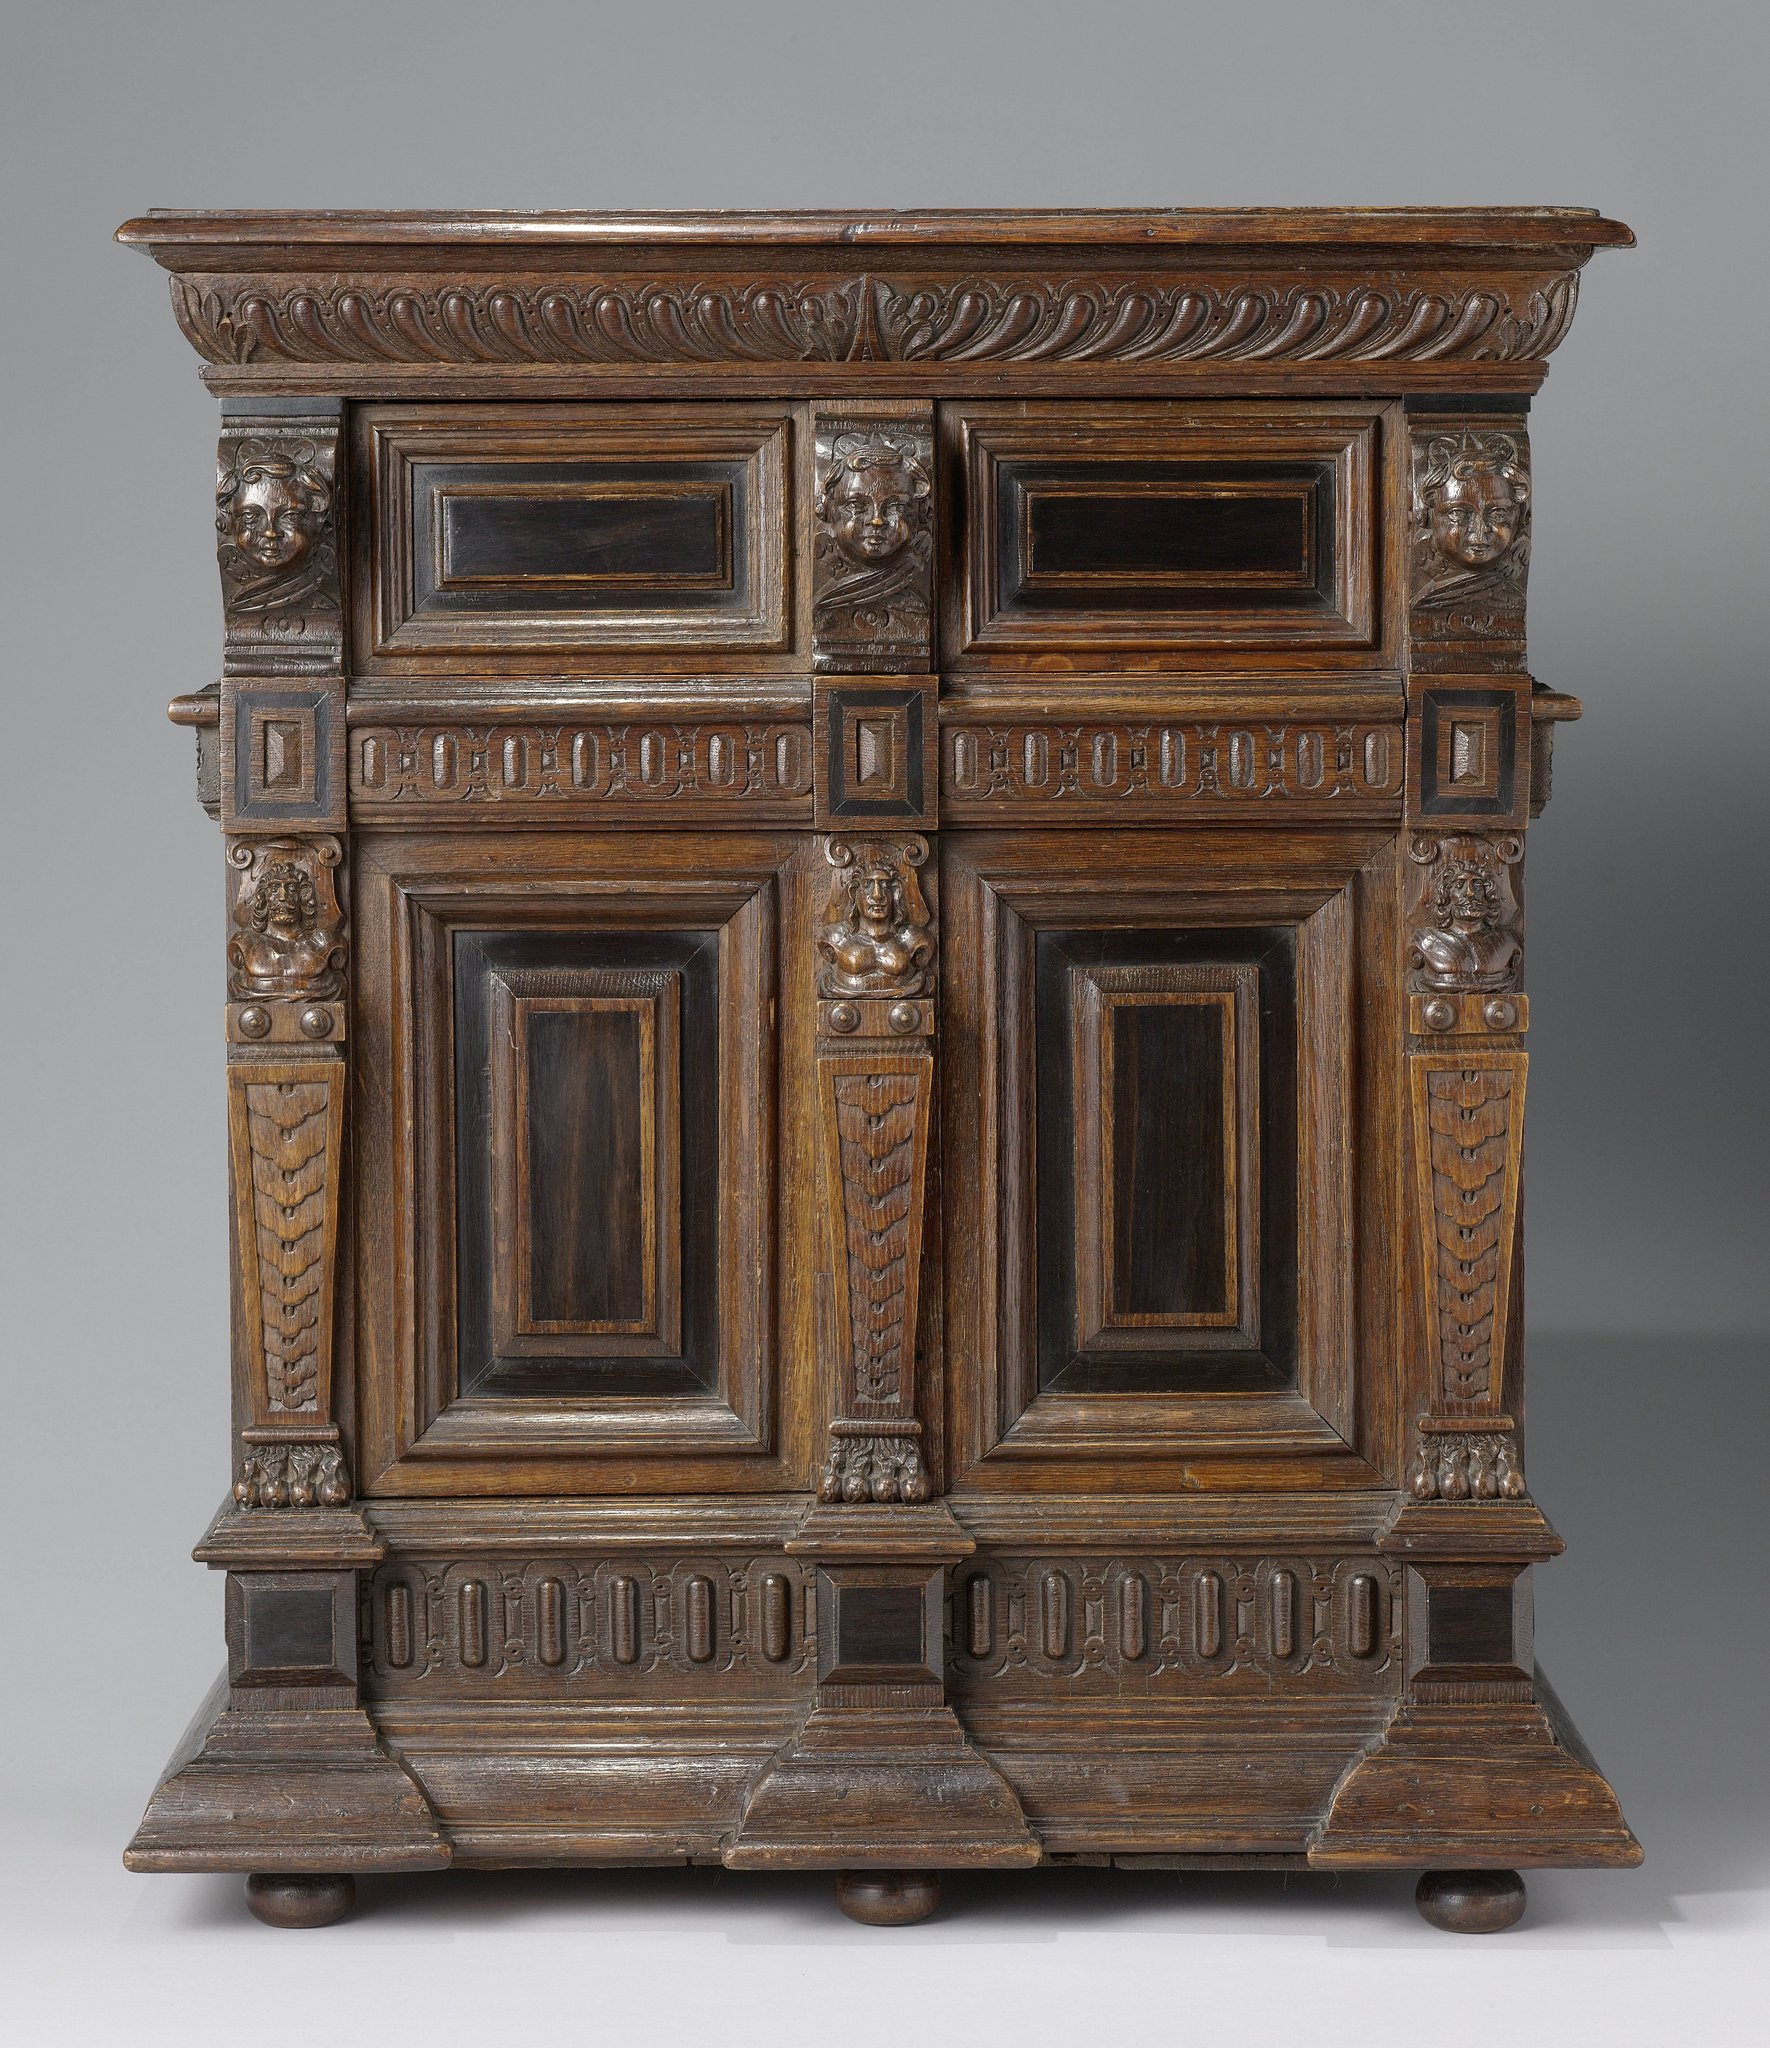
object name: miniature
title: Kast in miniatuur van eikenhout met twee laden tussen de deuren in boven- en onderkast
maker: Anonymous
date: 1850-1900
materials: wood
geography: northern netherlands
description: Cupboard. Oak and ebony. Netherlands, c. 1625-1650. Gift of Mr. and Mrs. De Bruijn-Van der Leeuw, 1961.